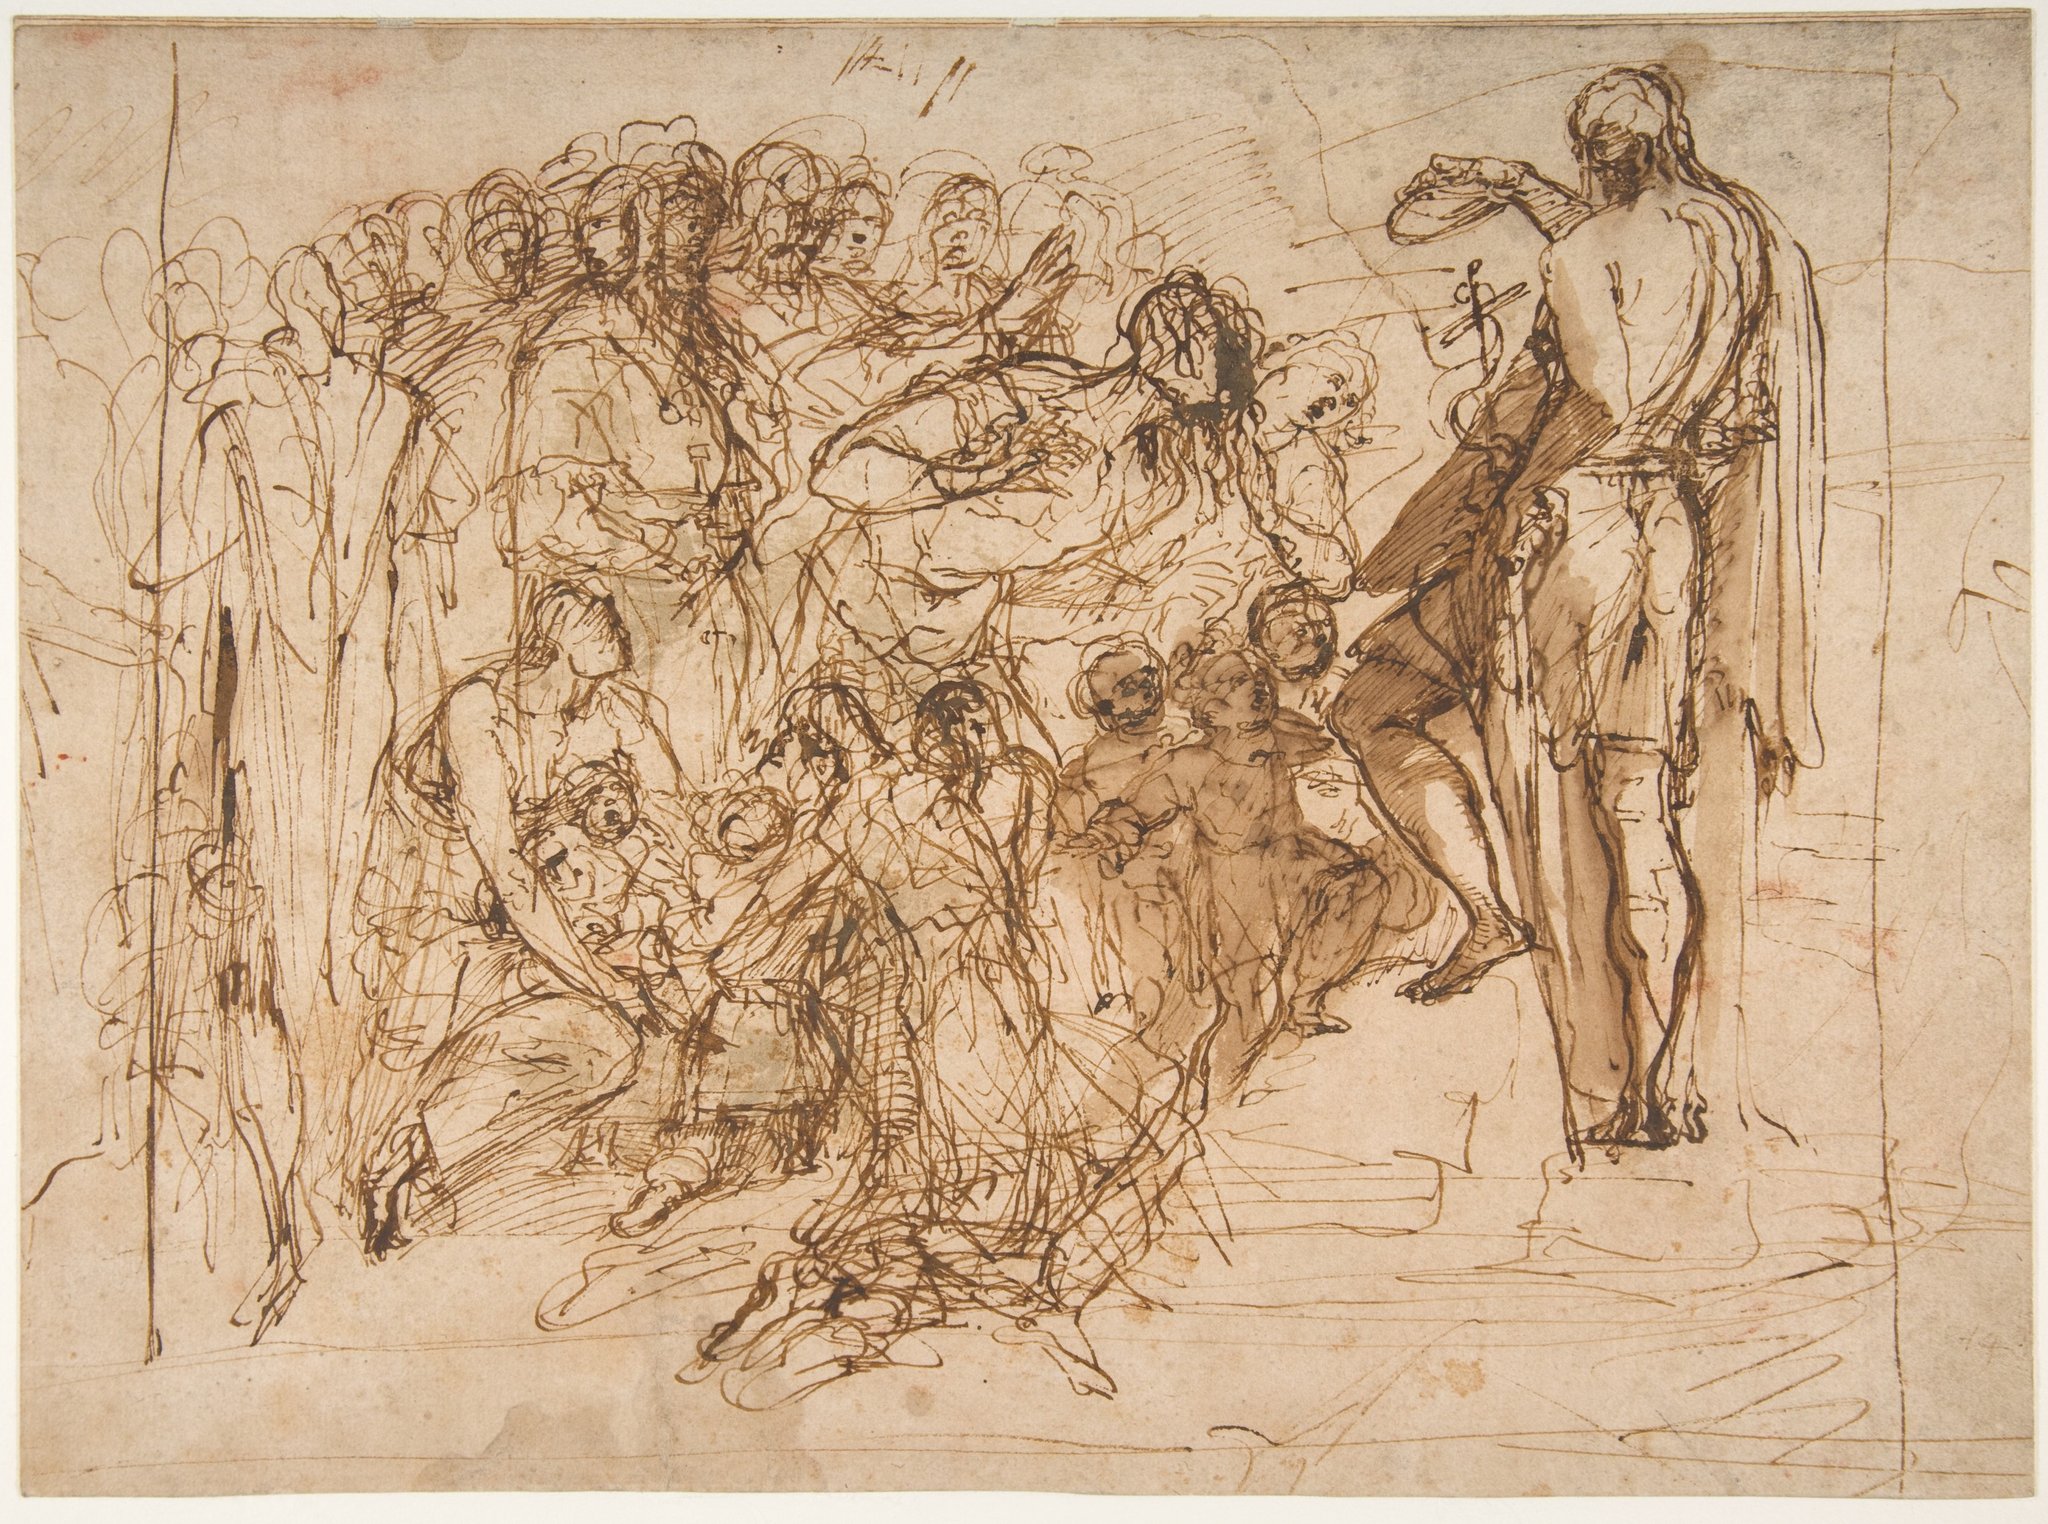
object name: drawing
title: Saint John the Baptist Baptizing the Multitude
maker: pellegrino tibaldi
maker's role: artist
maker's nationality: italian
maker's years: 1527-1596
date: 1554-1556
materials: ink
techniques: brush, pen, wash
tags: saint john the baptist,crowd